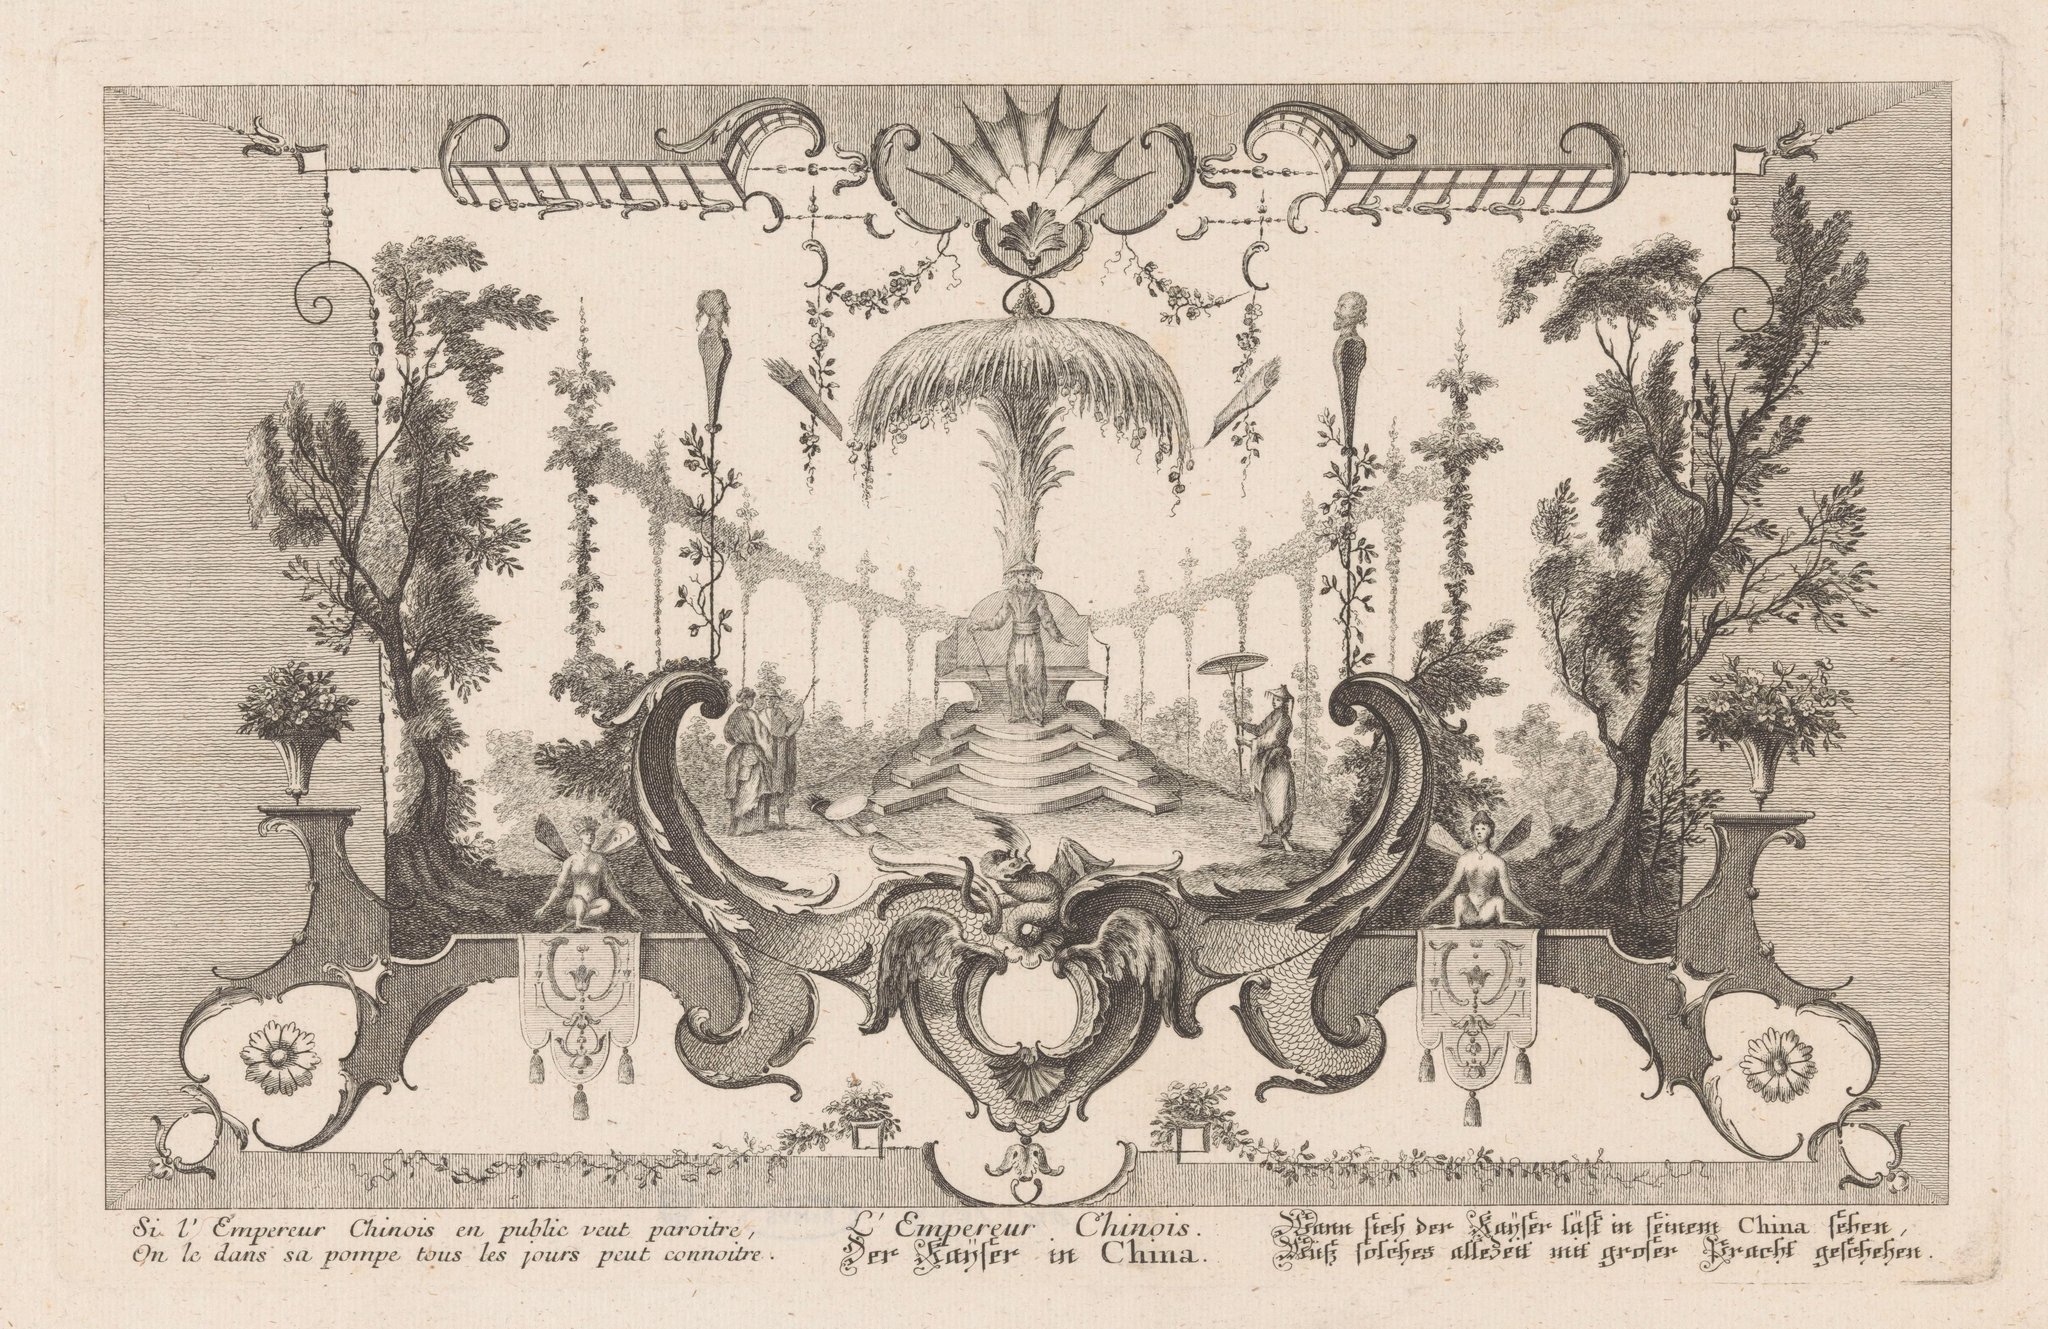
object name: print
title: Chinese keizer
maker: Anonymous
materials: paper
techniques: etching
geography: germany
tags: chinese, emperor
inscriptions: collector's mark: Lugt 2228, collector's mark: Lugt 2760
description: In een landschap staat in het midden een Chinese man, een keizer, voor een troon met trappartijen onder een natuurlijk baldakijn. Links staan twee mannen, rechts staat een man met een parasol. Rondom de voorstelling een geornamenteerde omlijsting met guirlandes, vazen met bloemen, rocailles, bloemmotieven, gevleugelde figuren en een draak. In de ondermarge een tweeregelige Franse en Duitse tekst.